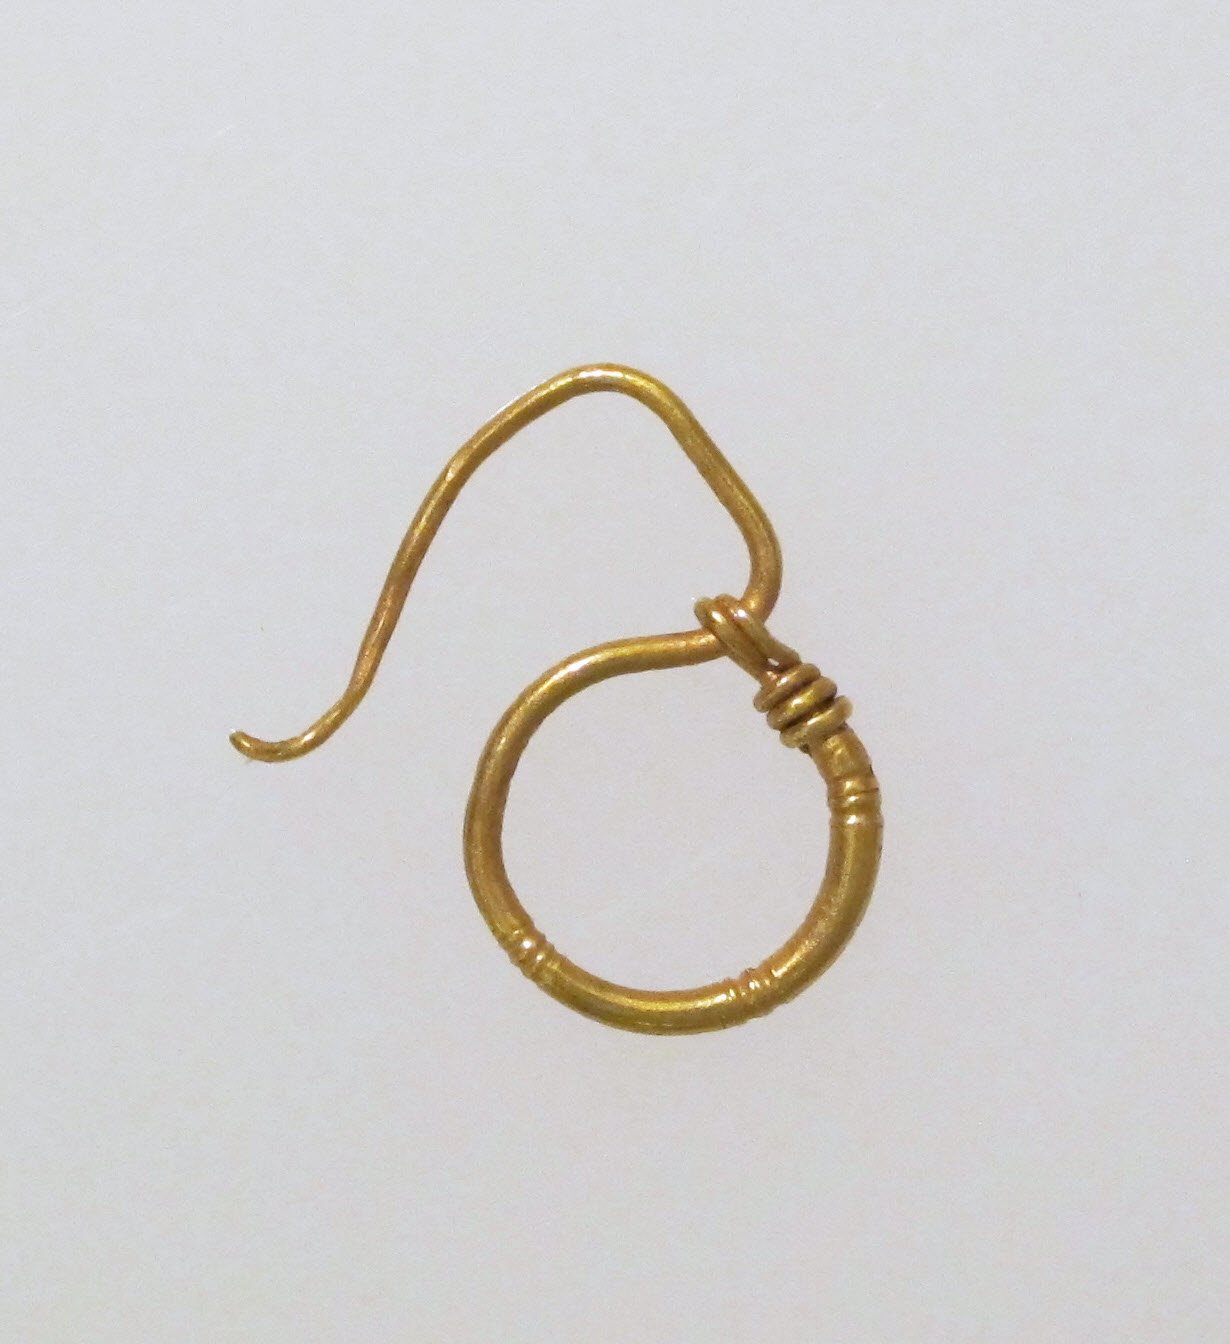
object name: earring, delta shaped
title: Earring, delta-shaped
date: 7000 BCE-330 CE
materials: gold